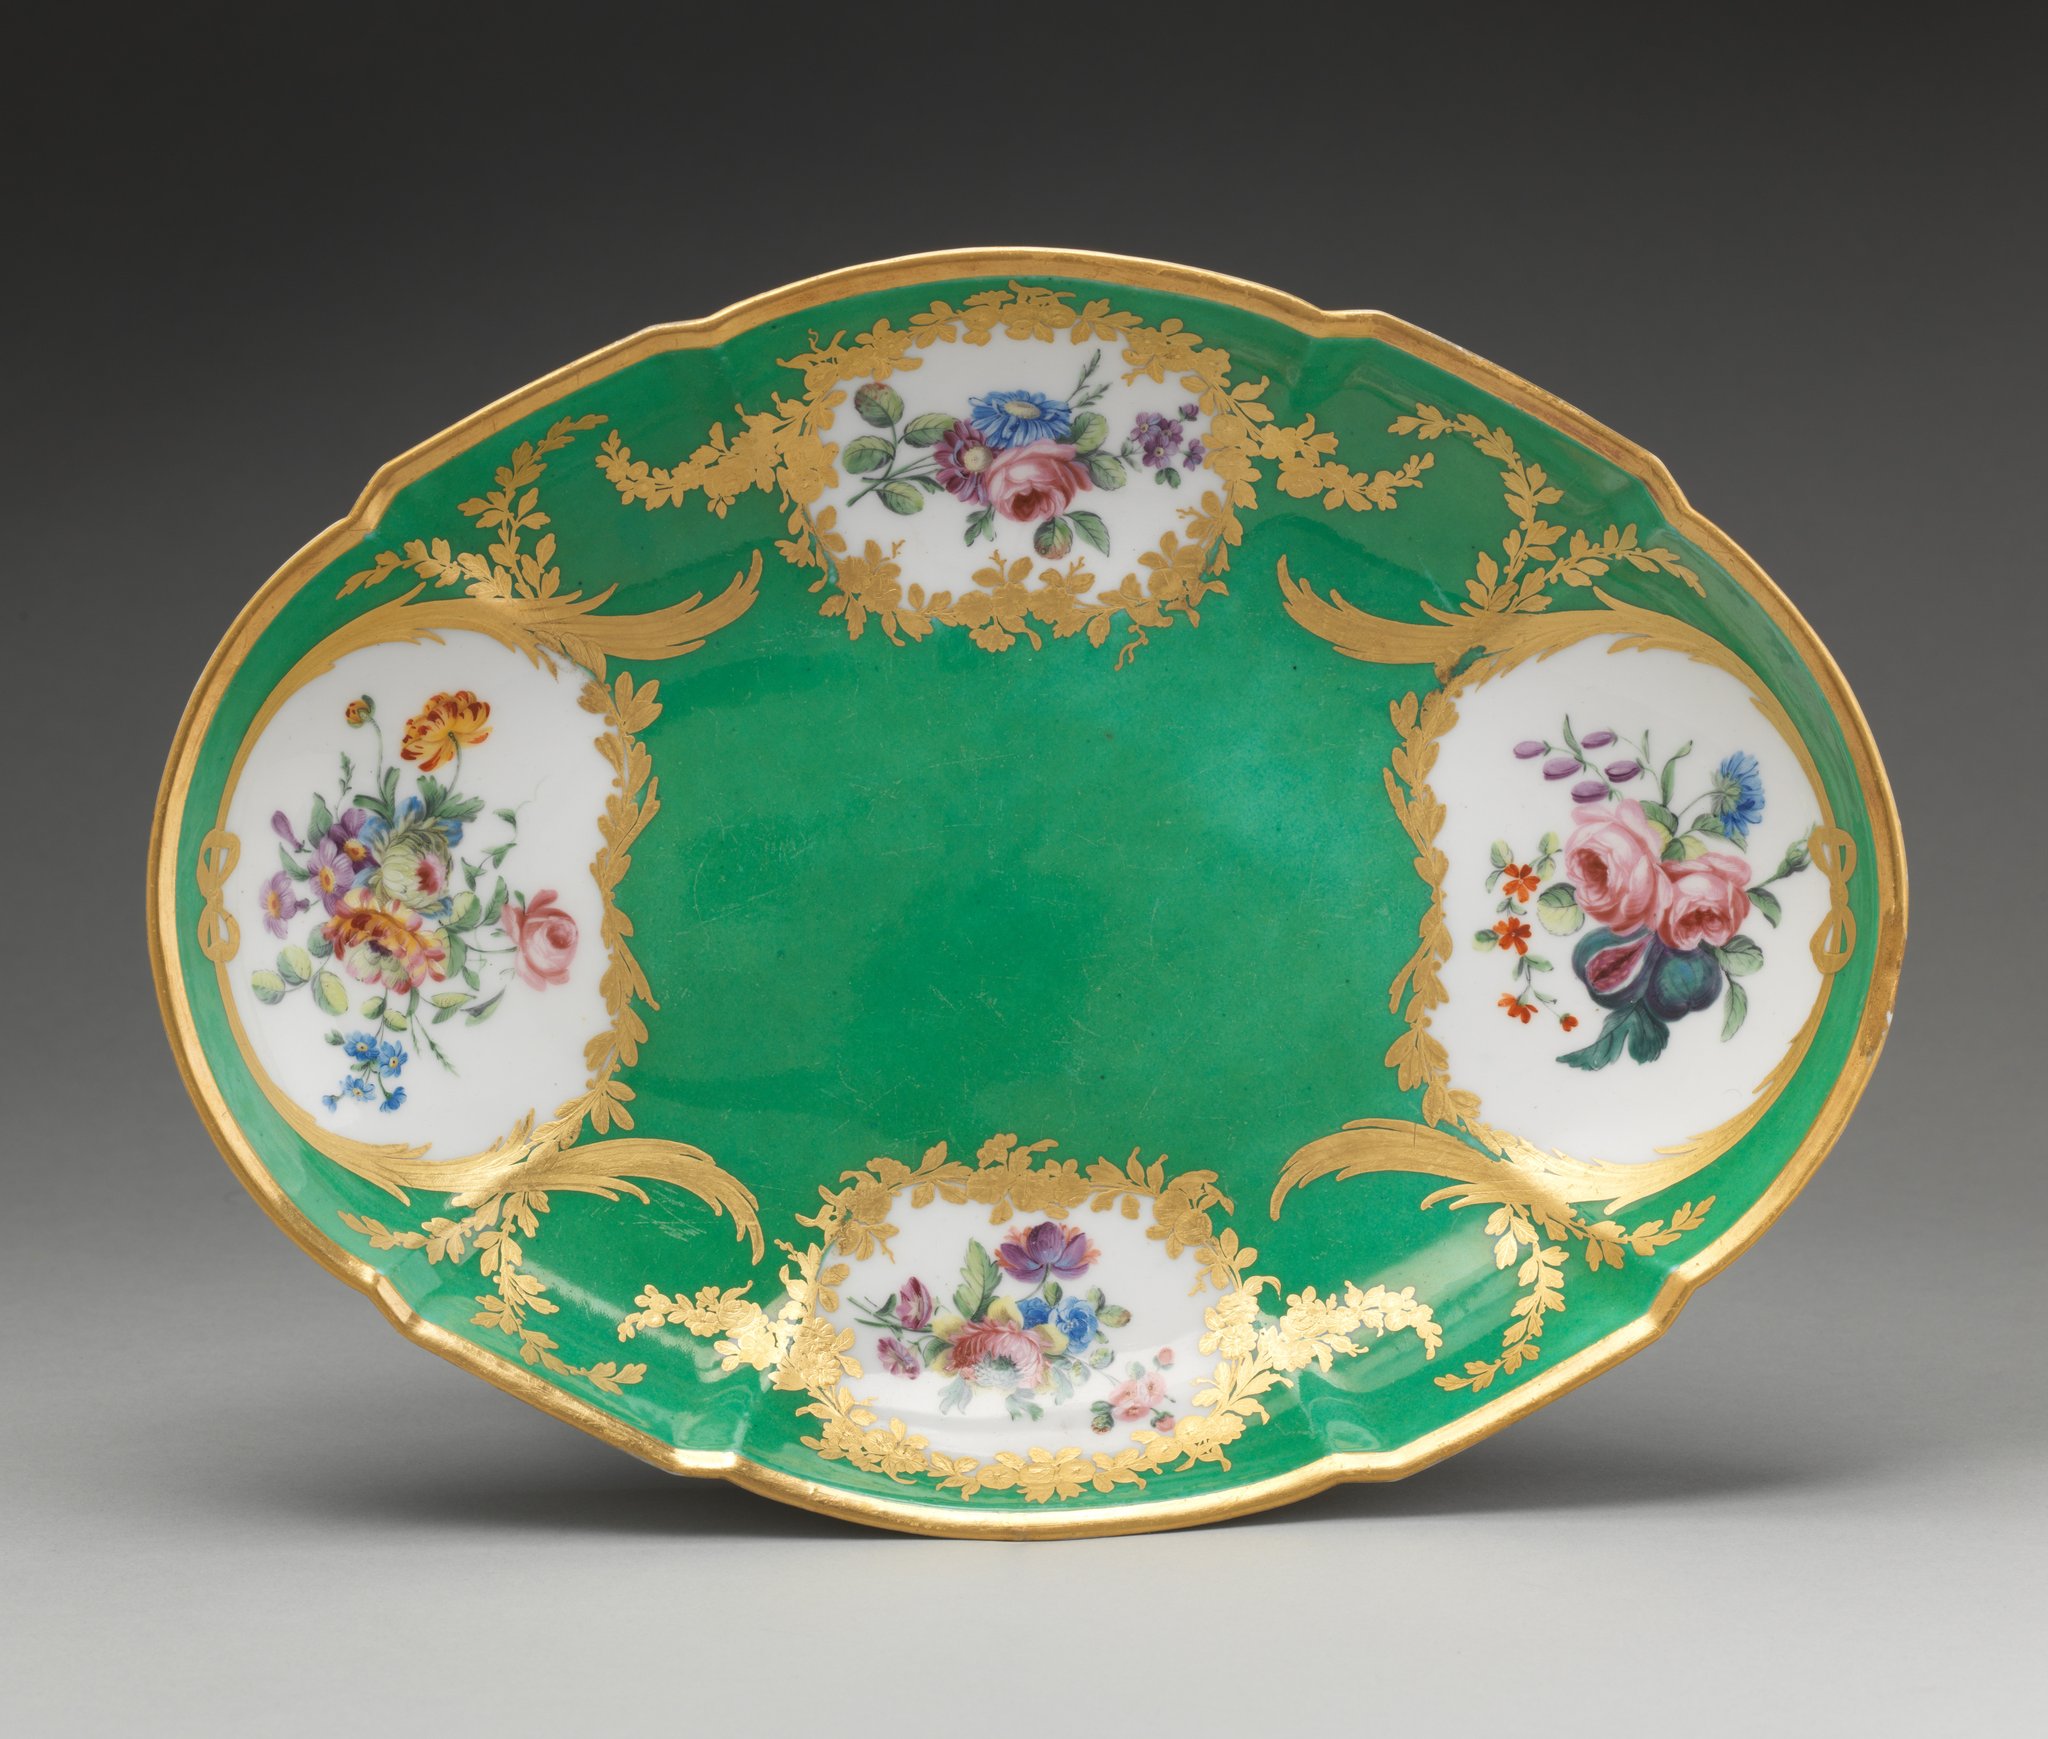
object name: fruit dish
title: Fruit dish (compotier ovale) (one of two) (part of a service)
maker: sèvres manufactory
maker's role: manufactory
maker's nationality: french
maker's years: 1740-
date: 1782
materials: soft paste porcelain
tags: flowers